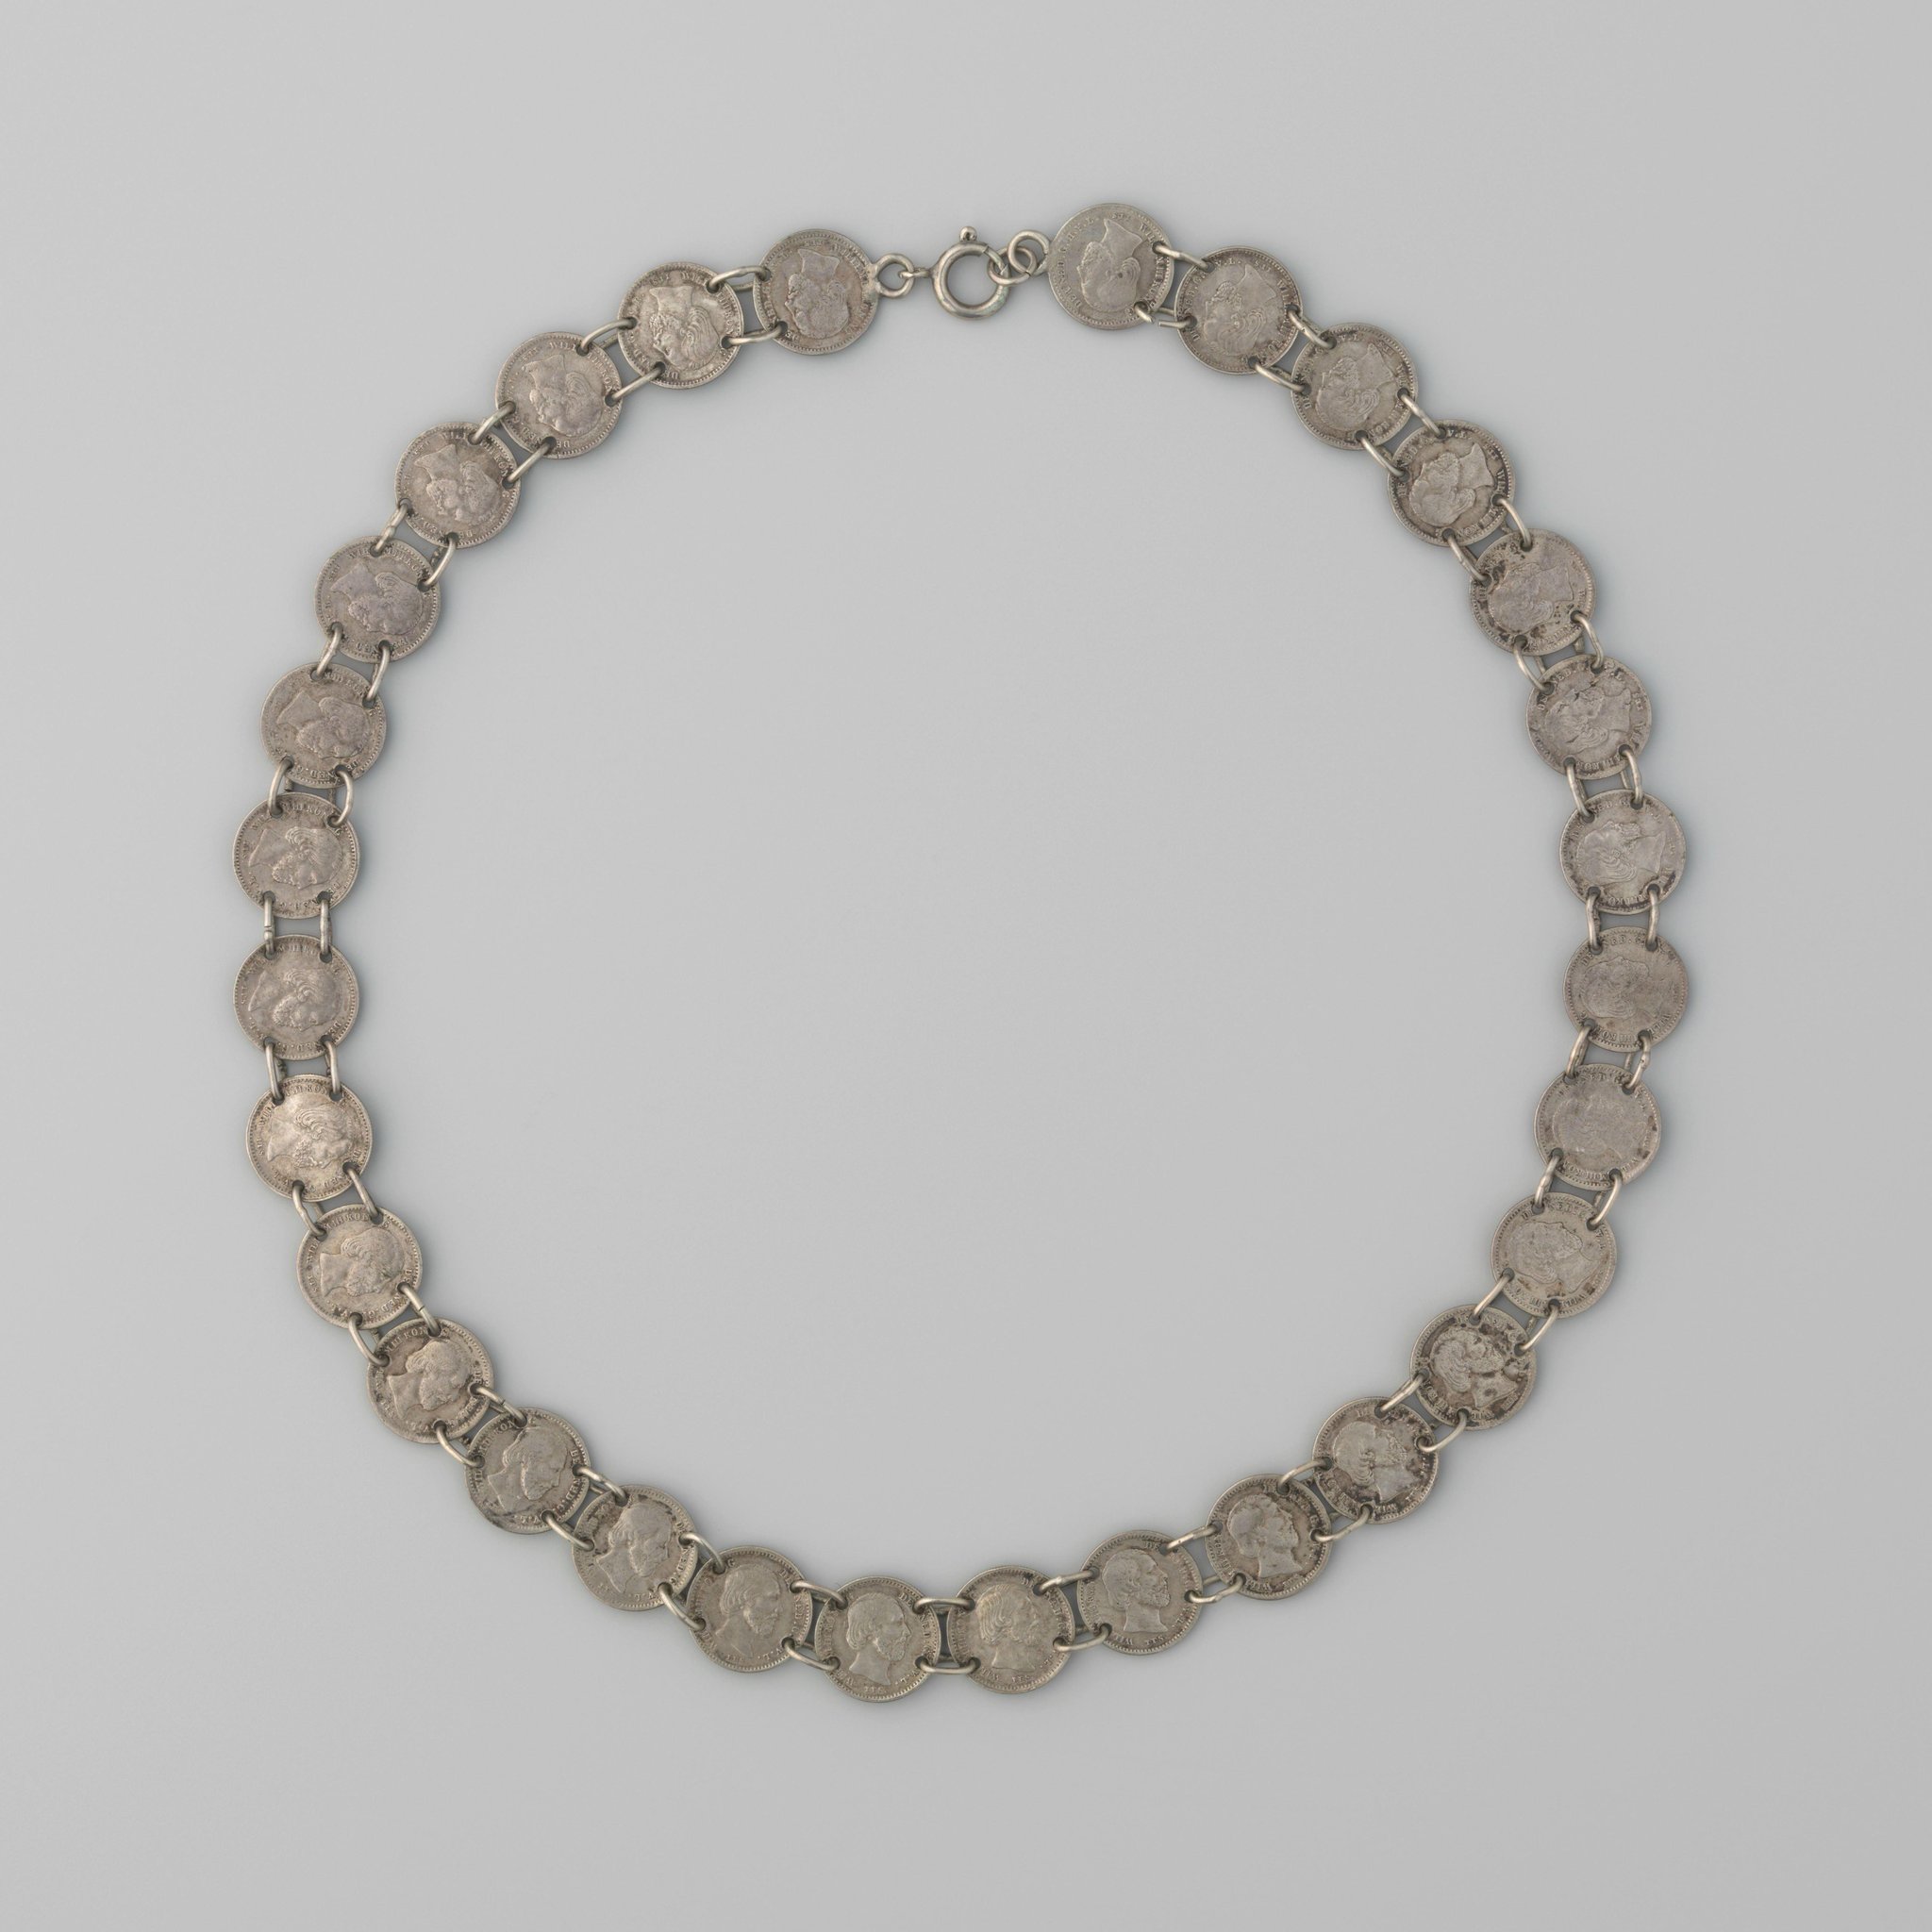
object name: necklace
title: Collier van Nederlandse stuivers met Willem III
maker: Anonymous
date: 1940-1950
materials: silver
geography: netherlands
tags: willem iii (koning der nederlanden)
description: Collier van dertig Nederlandse stuivers met Willem III door middel van ogen aan elkaar verbonden en voorzien van een veerringsluiting.